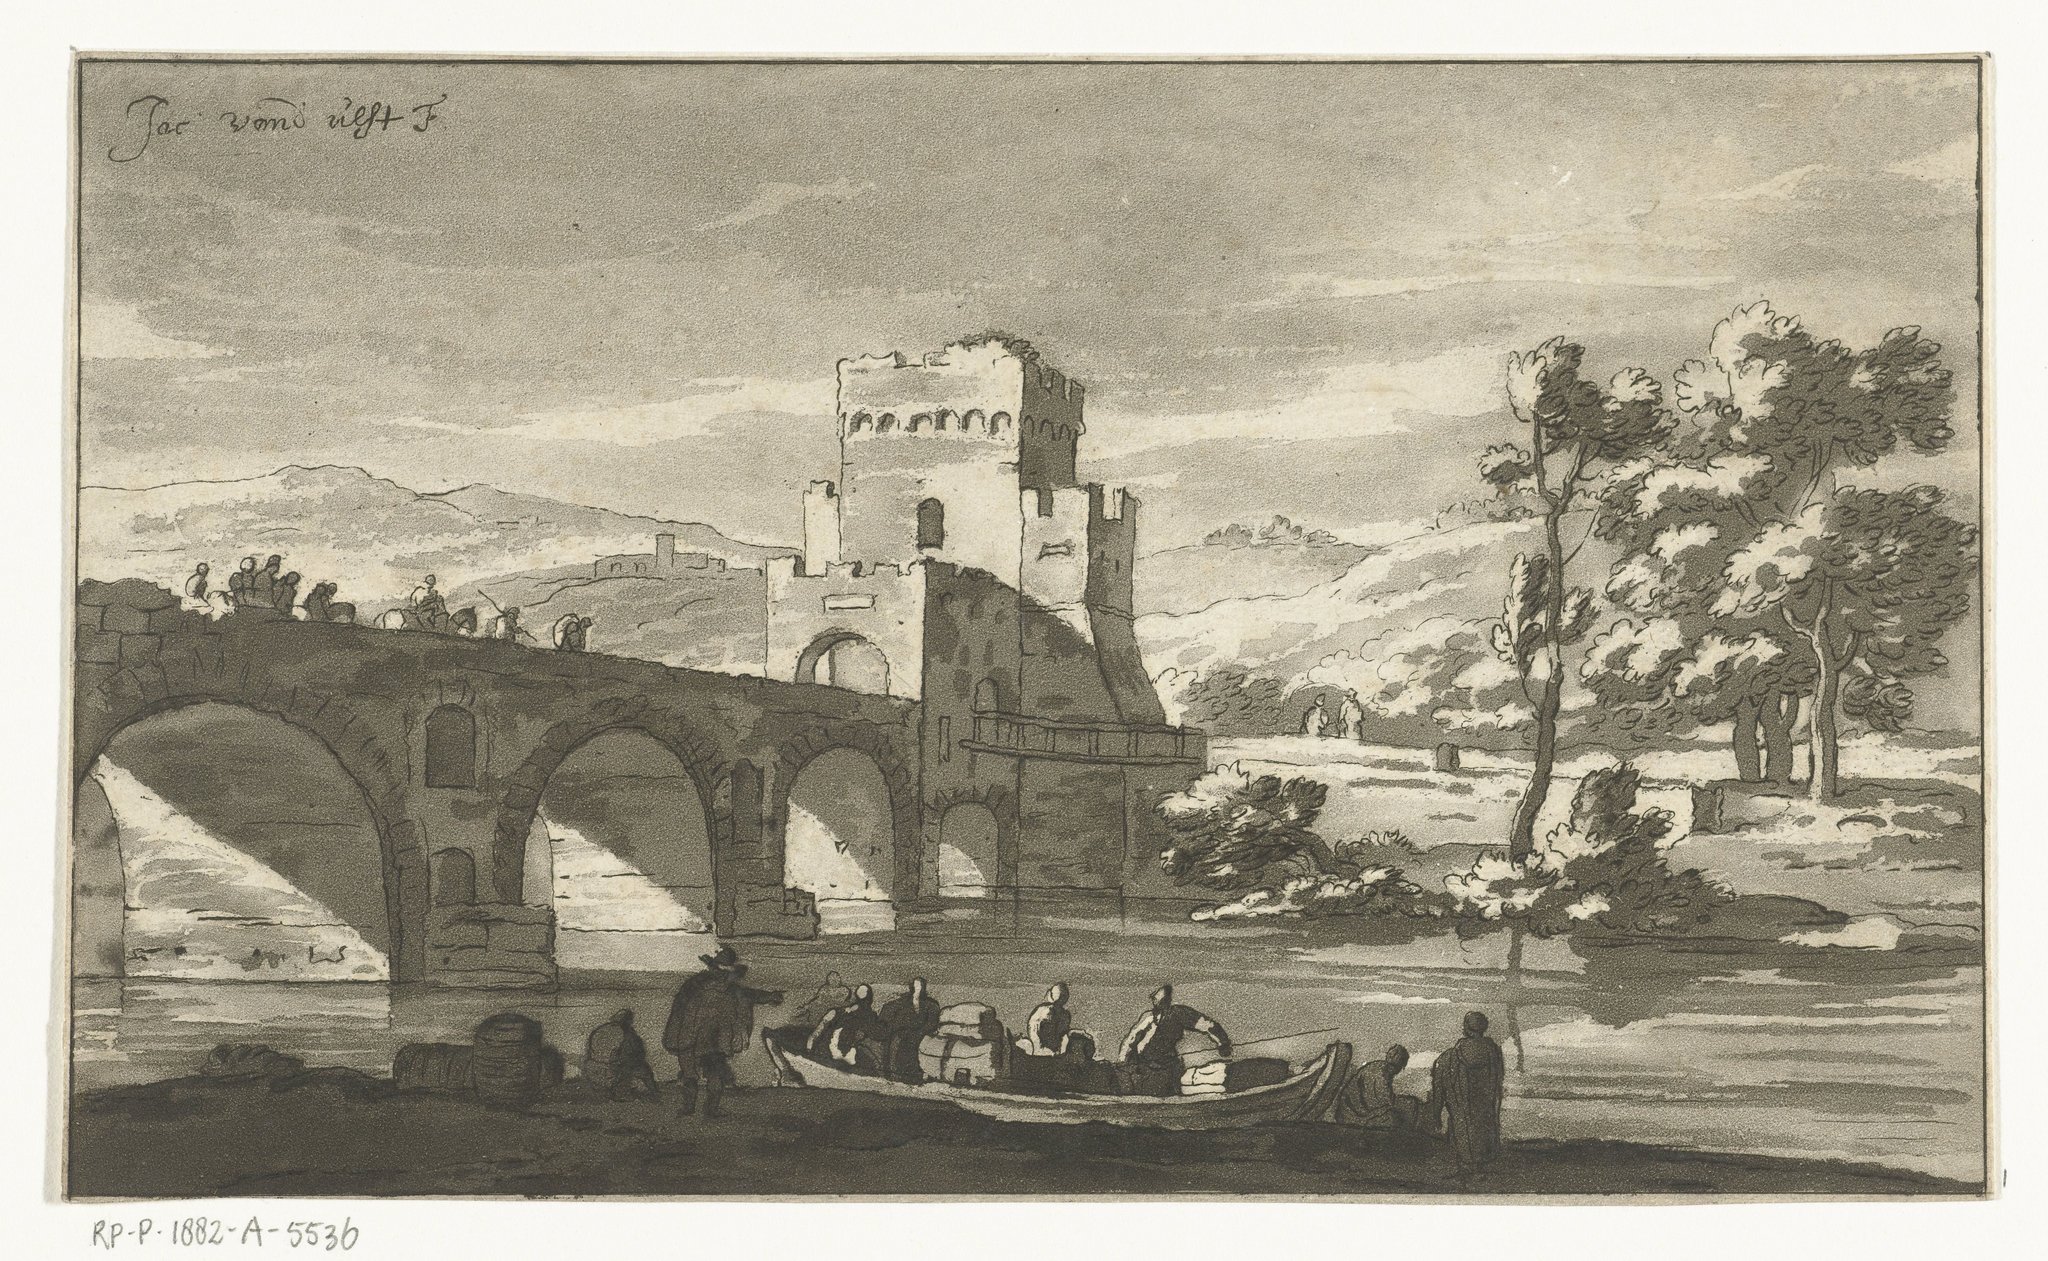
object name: print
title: Ponte Molle bij Rome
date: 1741-1803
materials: paper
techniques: aquatint, etching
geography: netherlands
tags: landscape with bridge, viaduct or aqueduct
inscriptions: collector's mark: Lugt 2228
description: Prent naar tekening van Jacob van der Ulft gedrukt met twee platen. Prent uit serie van negen prenttekeningen met acht landschappen en een zeegezicht naar Hollandse meesters uit de 17e eeuw, zie Huffel 1921, p. 33-35. De originele tekening van Jacob van der Ulft bevindt zich in de collectie van Fondation Custodia te Parijs.